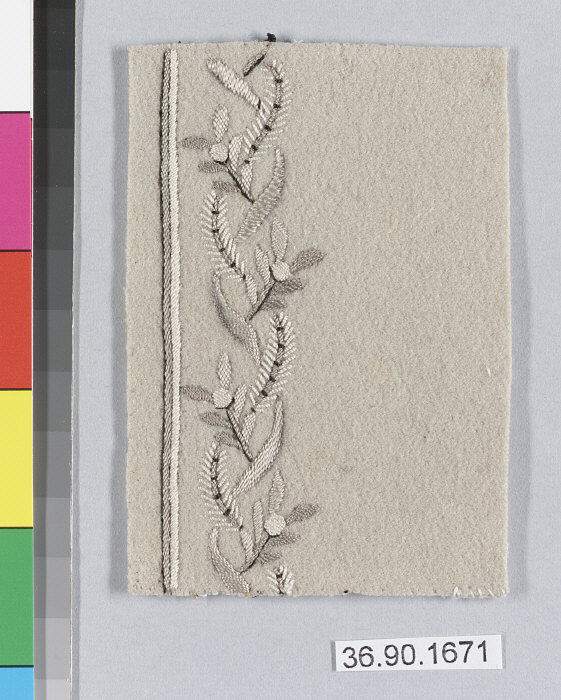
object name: sample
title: Embroidery sample for a man’s suit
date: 1785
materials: silk, wool